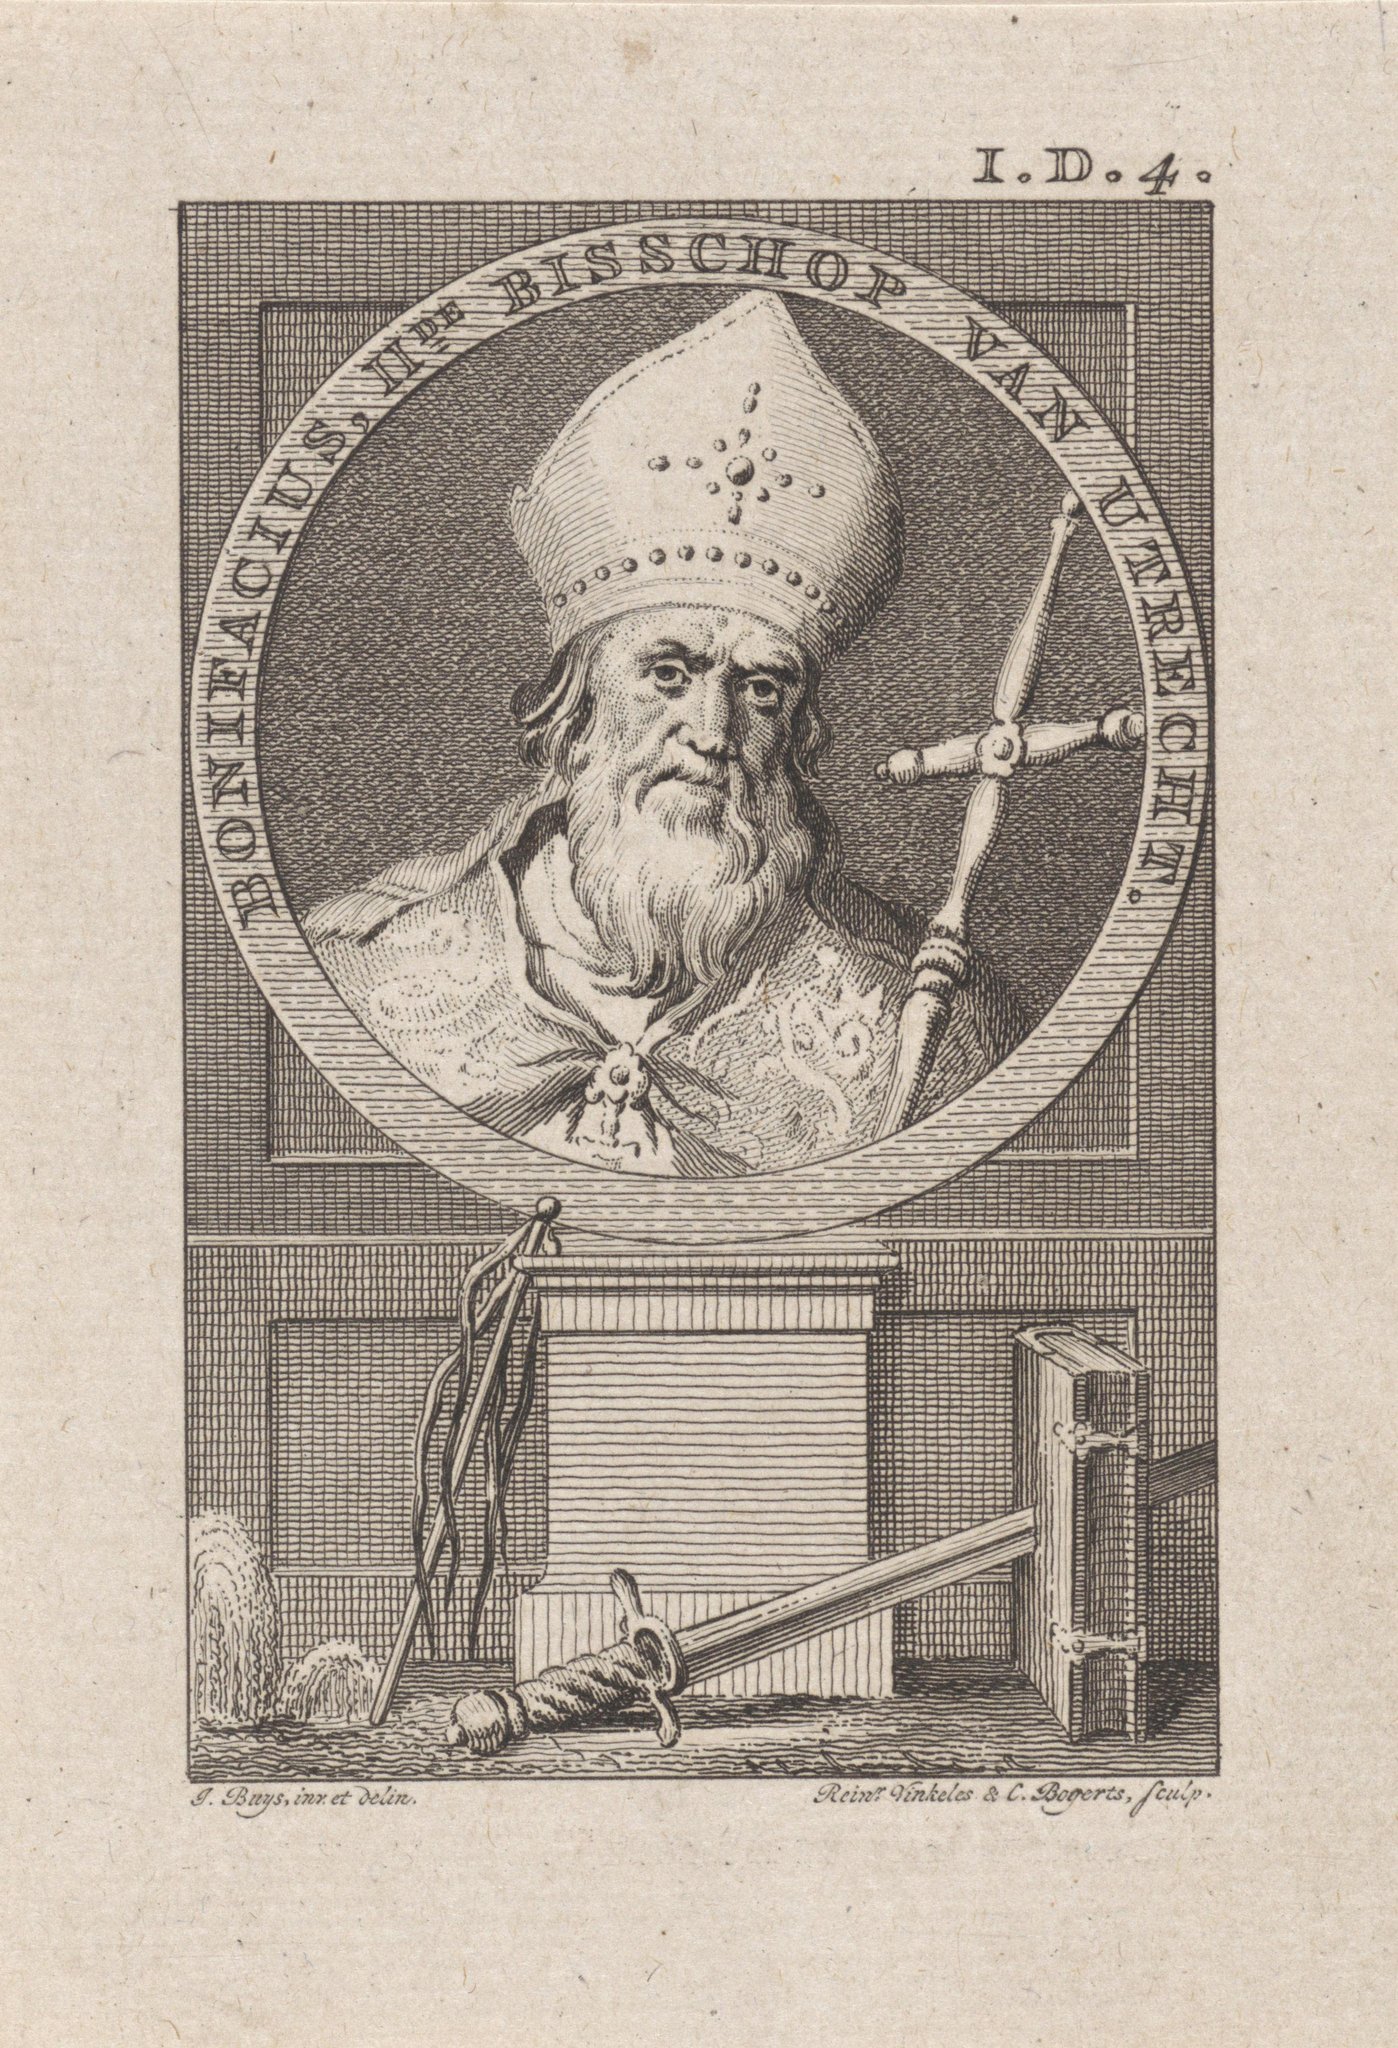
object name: book illustration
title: Portret van Bonifatius, tweede bisschop van Utrecht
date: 1783-1795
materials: paper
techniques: etching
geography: amsterdam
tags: crediton, bisschop, bonifatius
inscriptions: collector's mark: Lugt 2228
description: Prent gebruikt in: Fokke, Jan. Geschiedenissen der Vereenigde Nederlanden voor de vaderlandsche jeugd Ie-XXVste deel. Amsterdam: Johannes Allart, 1783-1795. Deel I.